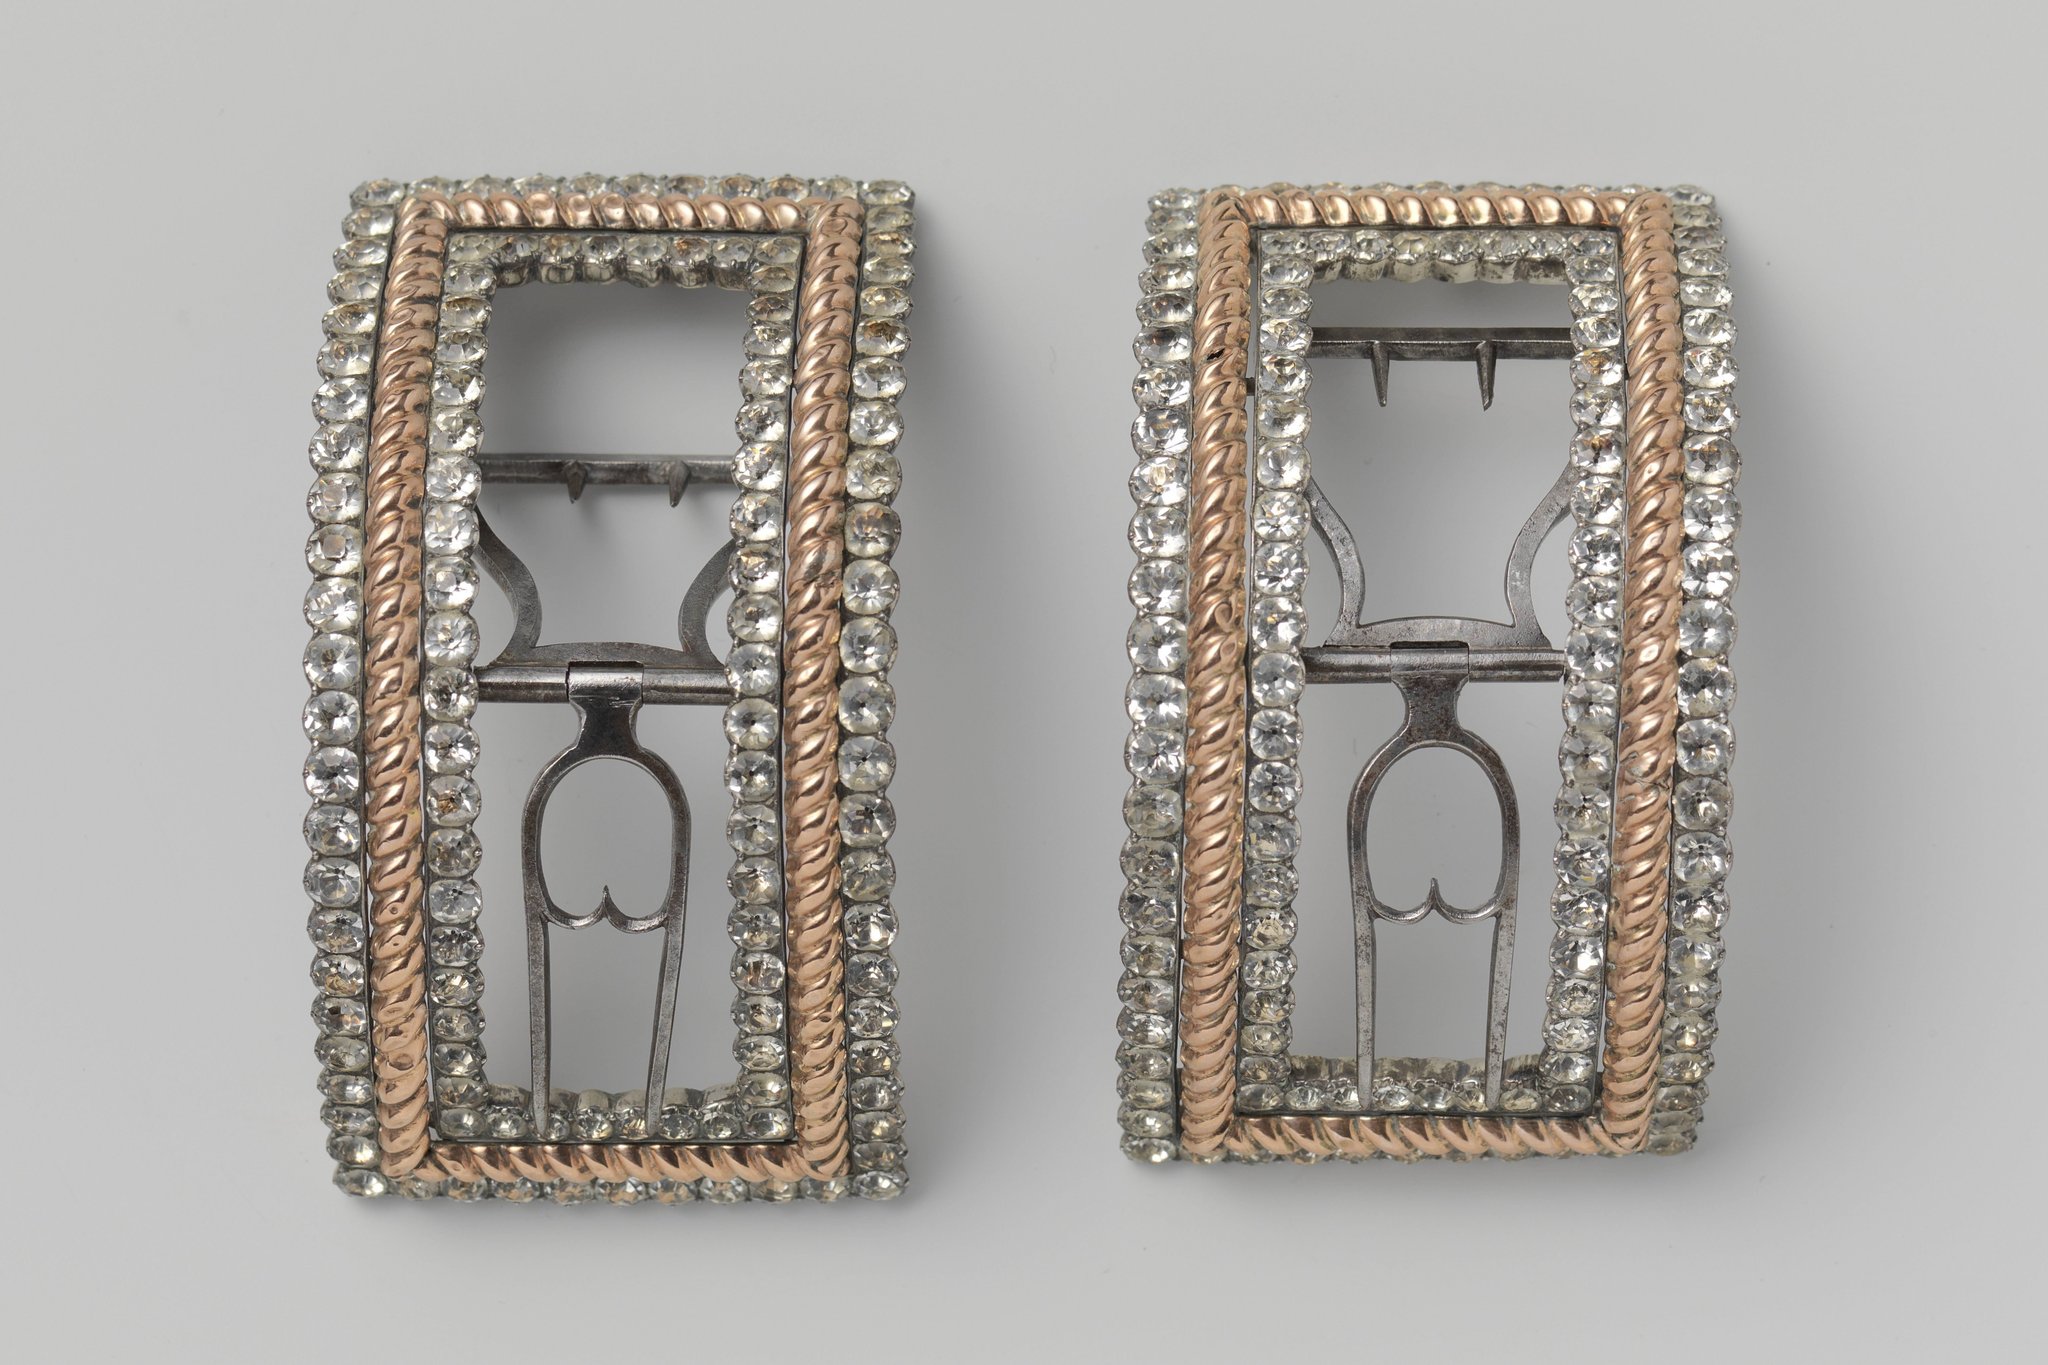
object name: shoe buckle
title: Schoengesp van stras met rand van verguld koper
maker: Anonymous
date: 1780-1800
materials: copper, metal, paste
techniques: gilding, grinding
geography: netherlands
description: Schoengesp van stras met rand van verguld koper. Om de gebogen, rechthoekige vorm zitten twee rijen geslepen stras, waartussen zich een rechthoekige getordeerde verguld koperen rand bevindt.